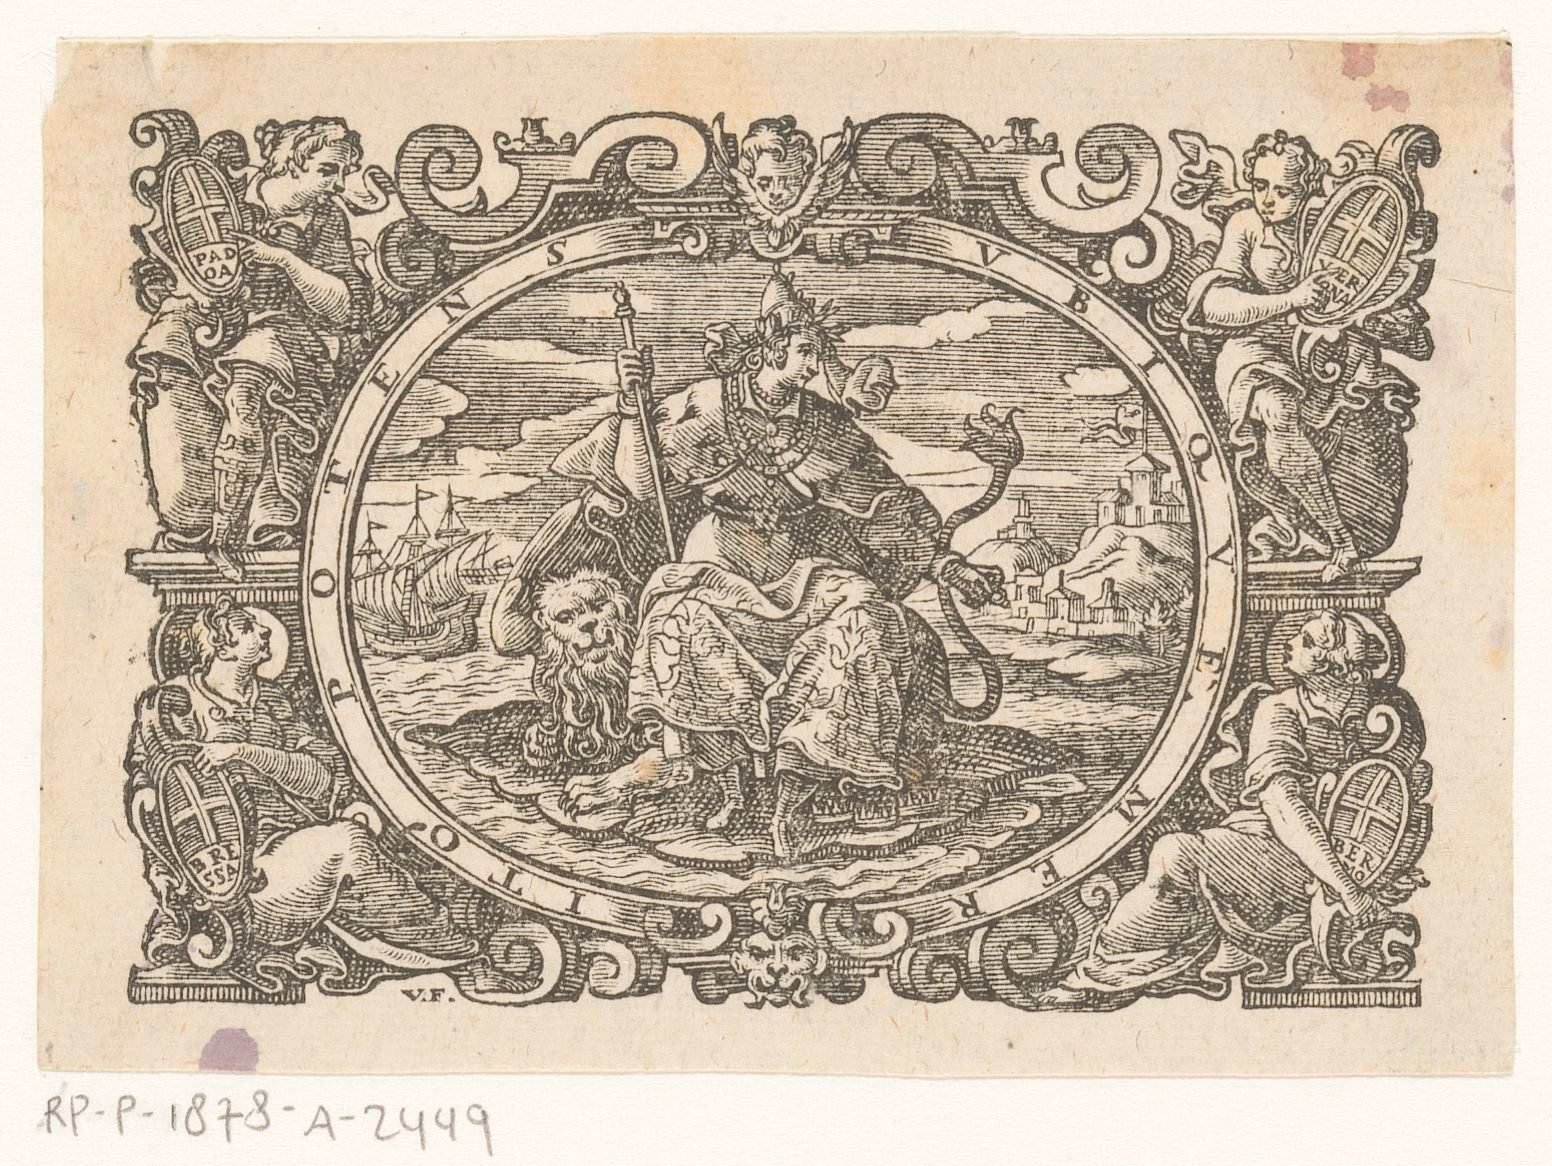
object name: print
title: Stedenmaagd van Venetië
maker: monogrammist vf (graveur)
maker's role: print maker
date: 1600-1699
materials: paper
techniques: woodcut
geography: italy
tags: island, personifications of countries, nations, states, districts, etc., sceptre, staff (symbol of sovereignty), ring, beasts of prey, predatory animals: lion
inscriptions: collector's mark: Lugt 2228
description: Op een eiland zit de Venetiaanse stedenmaagd met een scepter en een leeuw naast zich. In haar linkerhand houdt ze de ring van het huwelijk tussen Venetië en de Adriatische Zee. De voorstelling is gevat in een ovaal met daarin de tekst: ubique merito potens. In de hoeken zitten vrouwen met wapenschilden met daarop de namen van de steden Padua, Verona, Bergamo en Brescia.